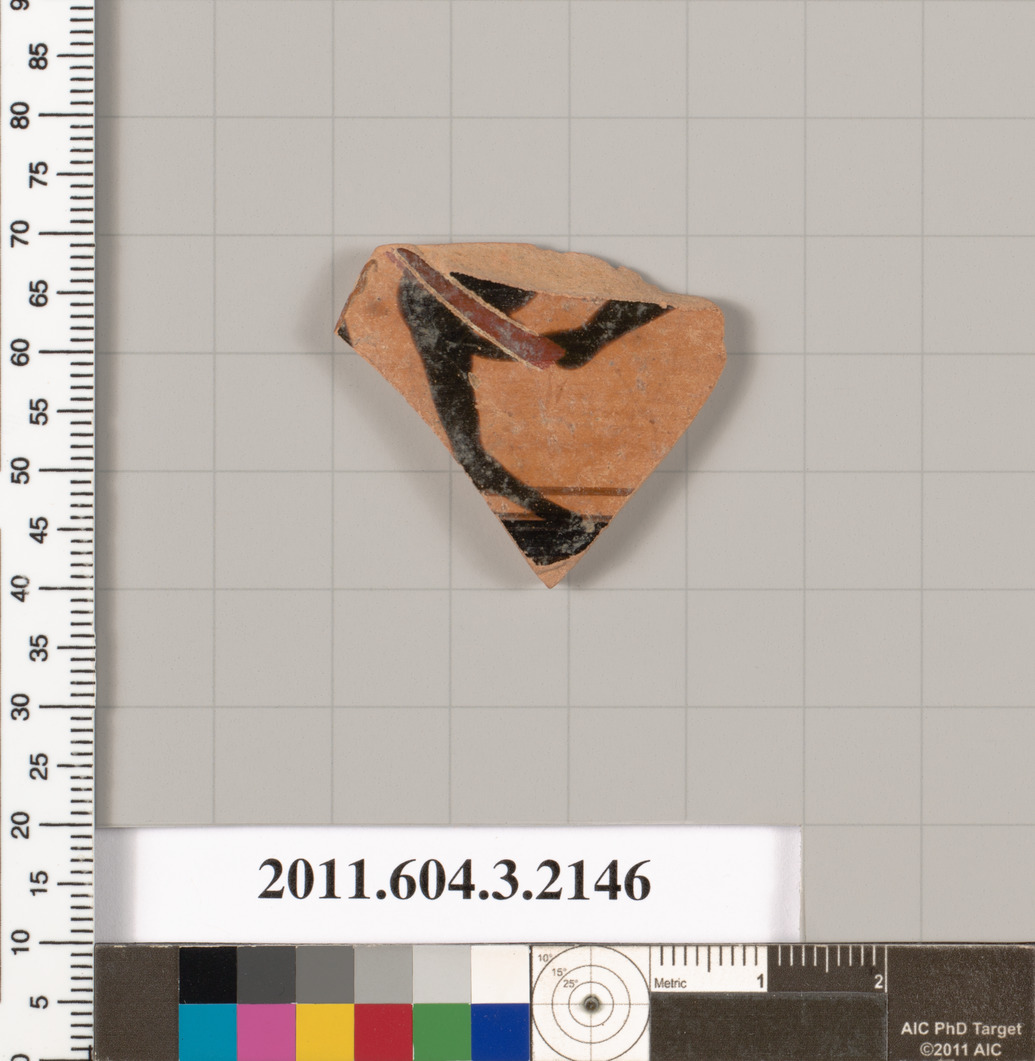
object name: kylix fragment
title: Terracotta fragment of a kylix (drinking cup)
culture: greek, attic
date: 534-501 BCE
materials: terracotta